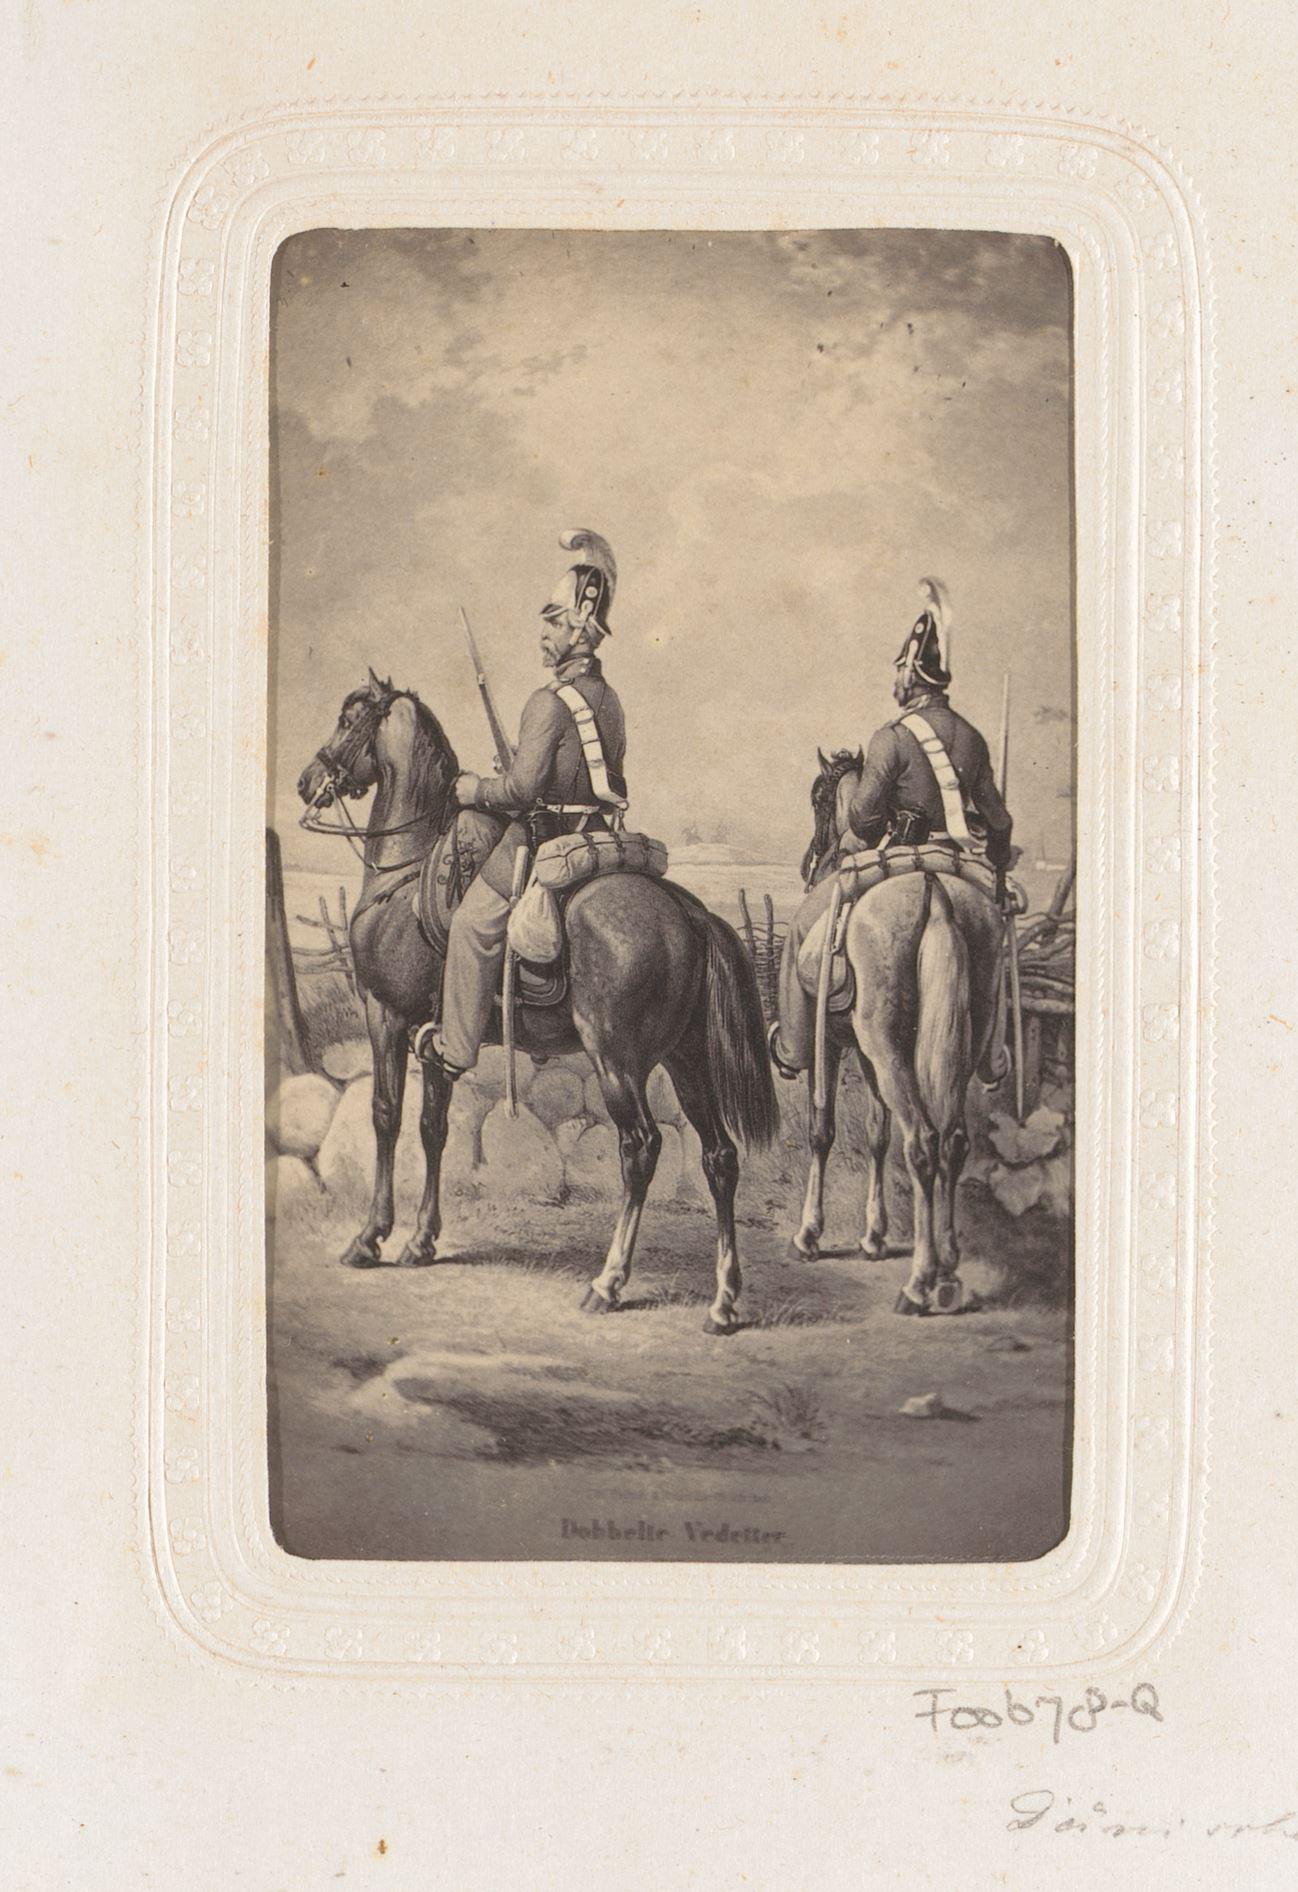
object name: album leaf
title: Fotoreproductie van een schilderij met twee ruiters te paard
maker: Anonymous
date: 1860-1880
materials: cardboard, photographic support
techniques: albumen print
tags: riding a horse, ass, or mule; rider, horseman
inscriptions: annotation: ‘Danische Armee’